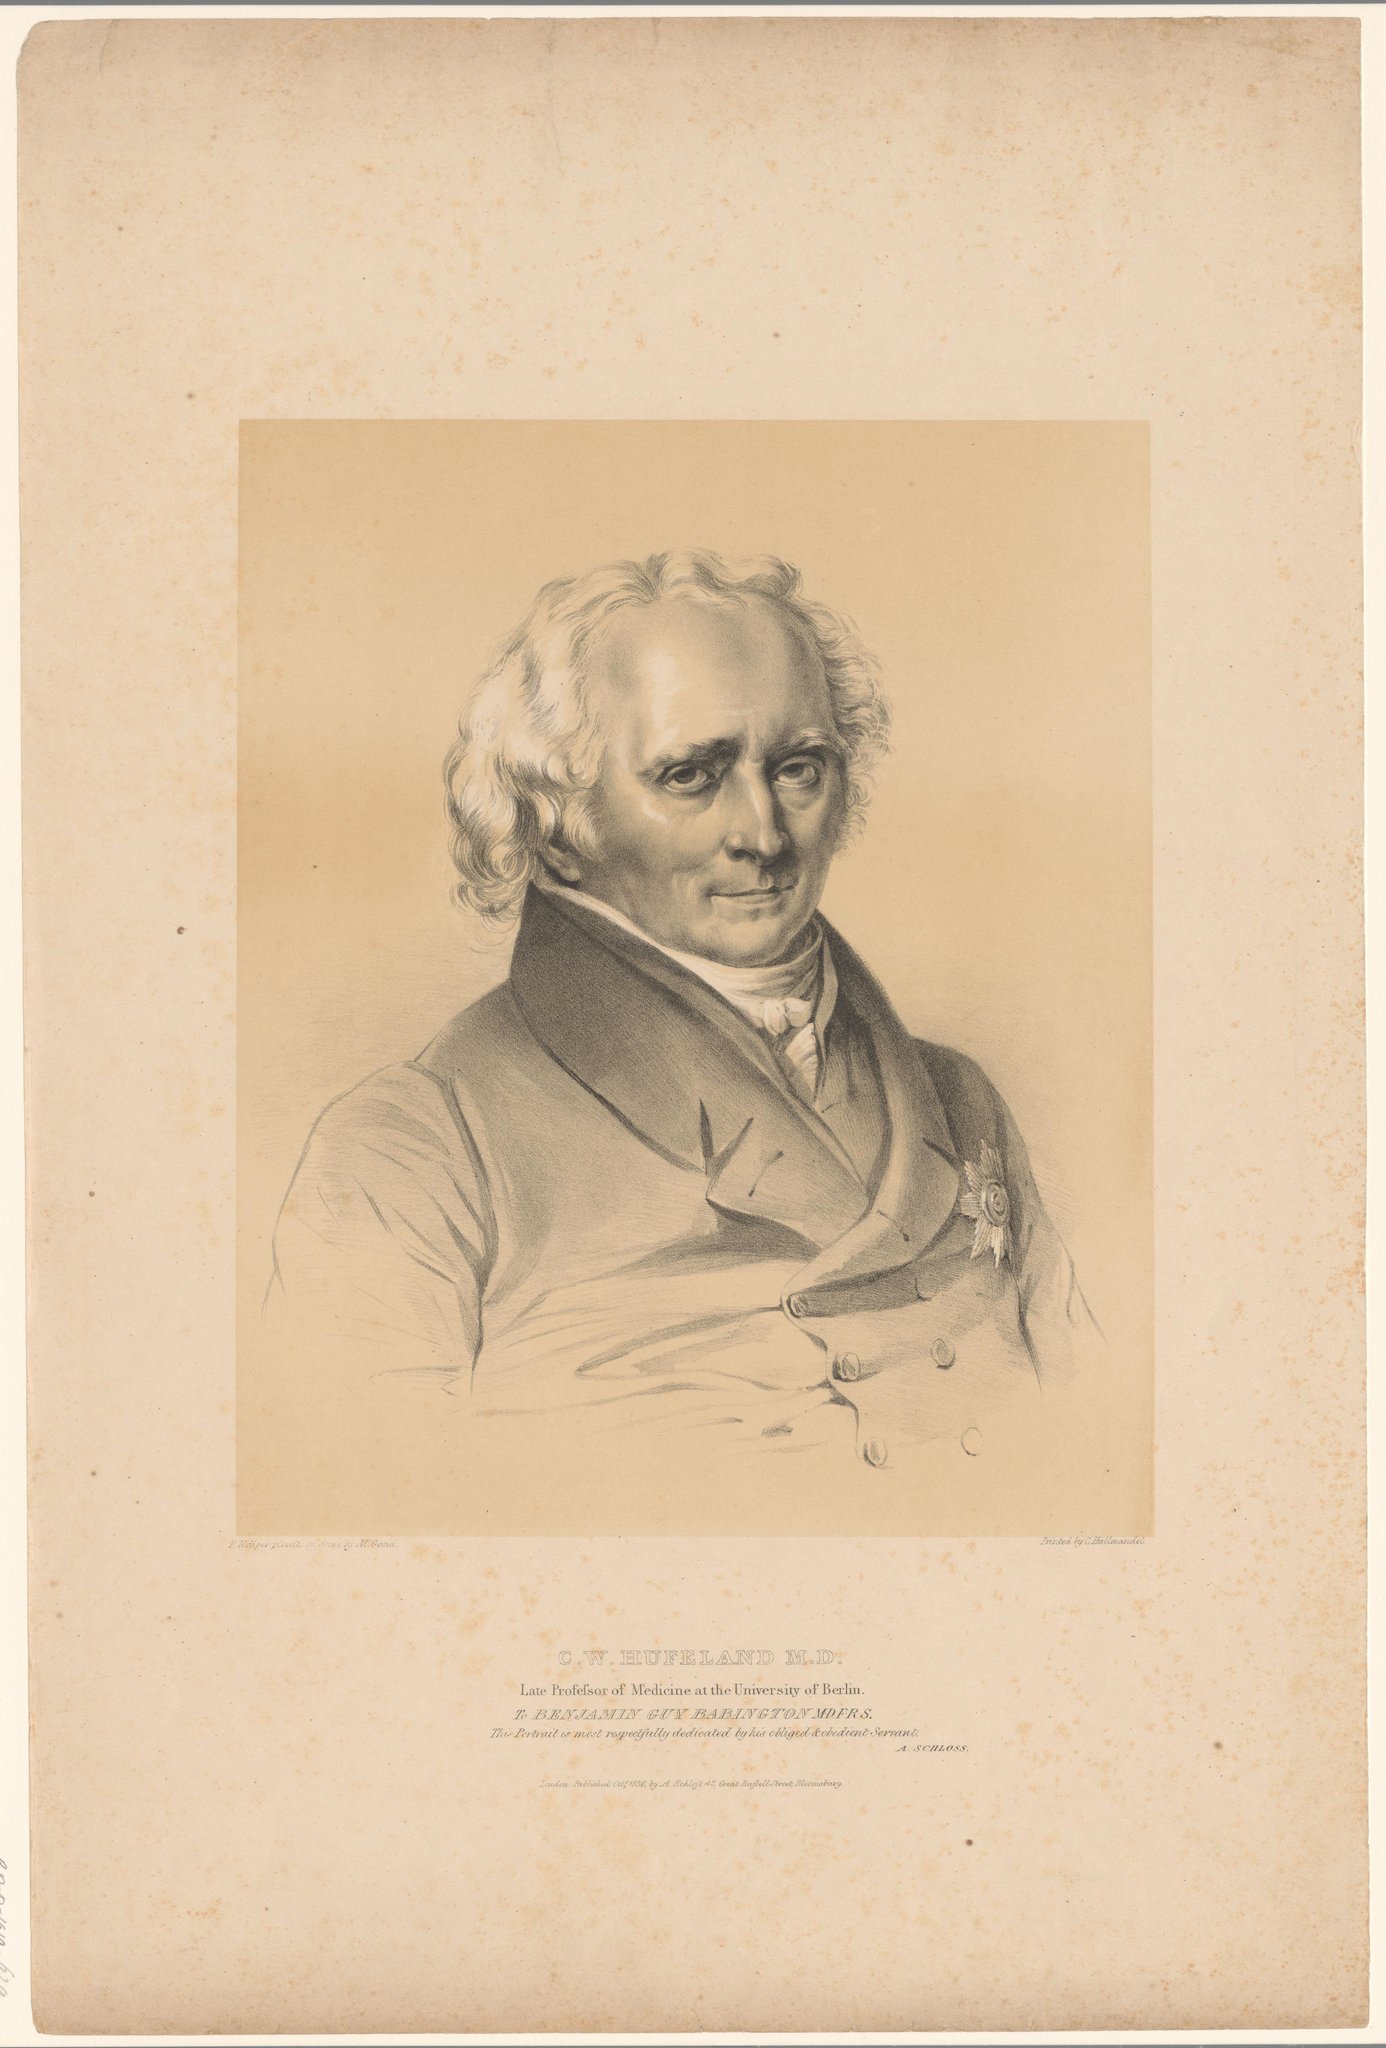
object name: print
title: Portret van Christoph Wilhelm von Hufeland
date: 1836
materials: paper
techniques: tone lithography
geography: london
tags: berlin, adult man, historical persons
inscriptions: collector's mark: Lugt 2228